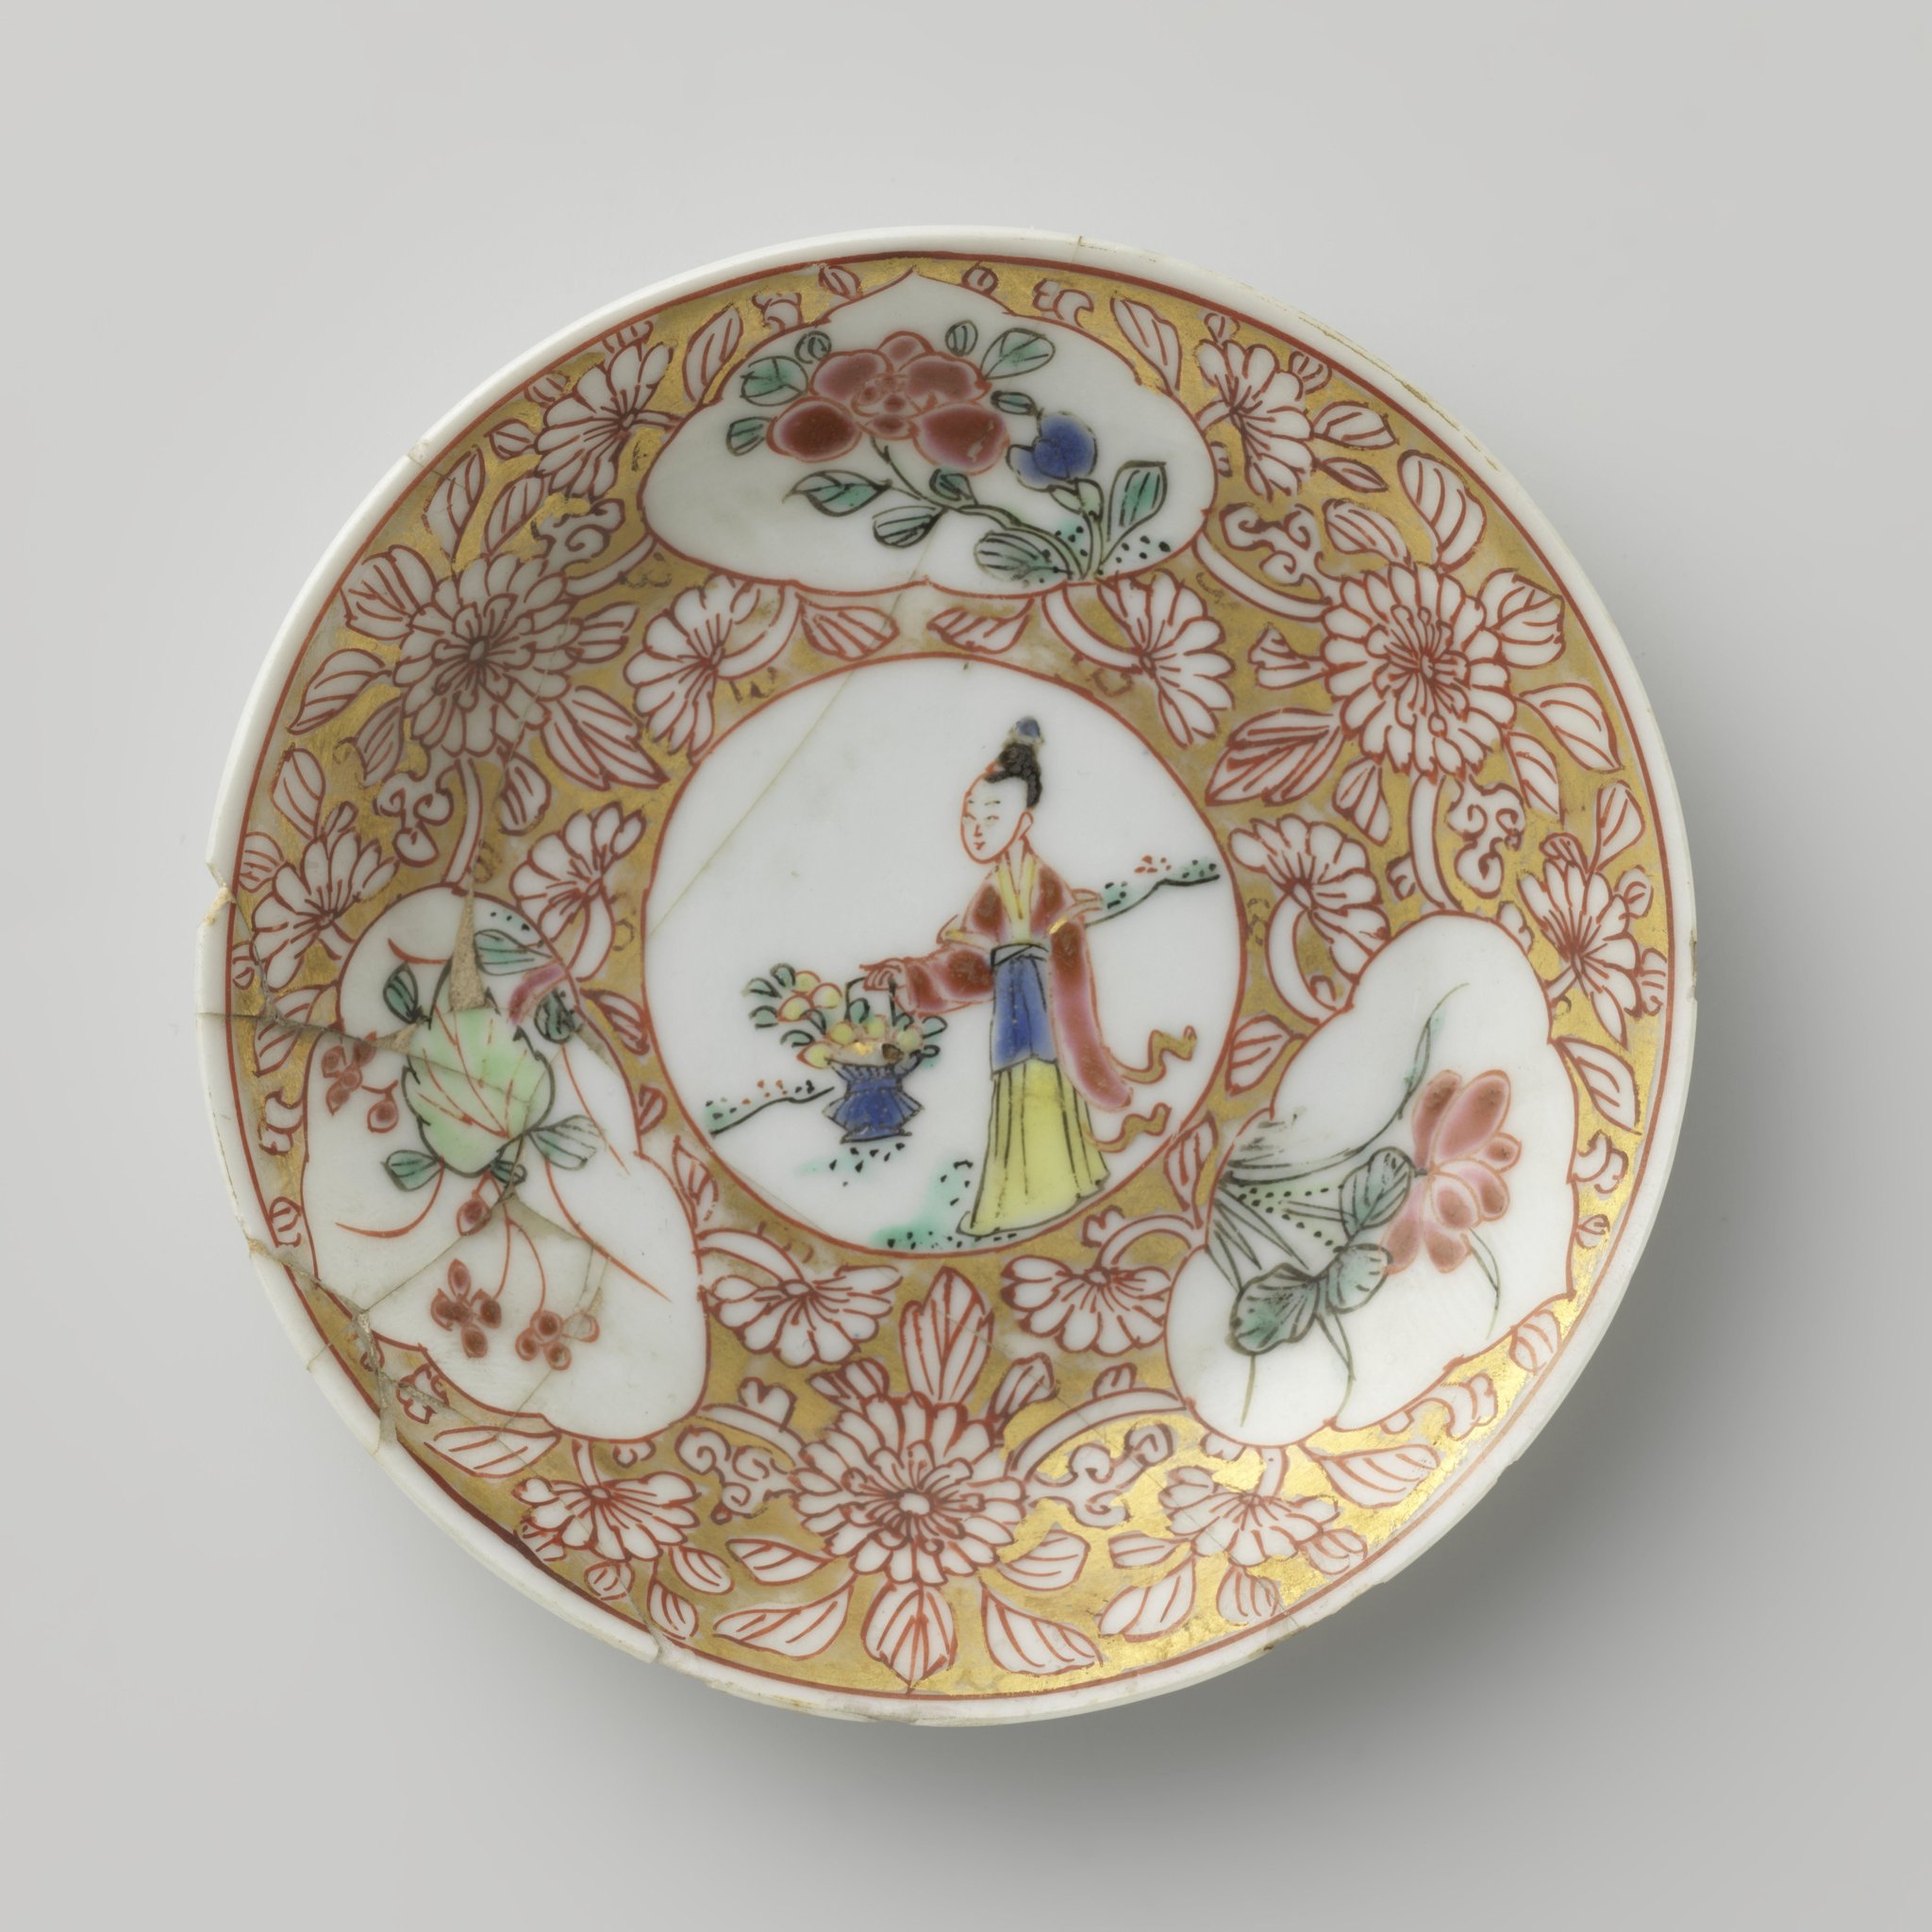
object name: platter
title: Saucer with a woman with flower basket and flowering plants in panels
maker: Anonymous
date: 1725-1749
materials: glaze, gold, paint, porcelain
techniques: firing, gilding, turning, vitrification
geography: china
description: Schotel van porselein met spreidende wand, beschilderd op het glazuur in blauw, rood, roze, groen, zwart en goud. Op het plat van de schotel een medaillon met een vrouw in een landschap met een bloemenmand; om het medaillon uitgespaarde bloemranken en drie cartouches met bloeiende planten (o.a. lotus) in een gouden grond. Schotel is gebroken geweest. Famille rose.